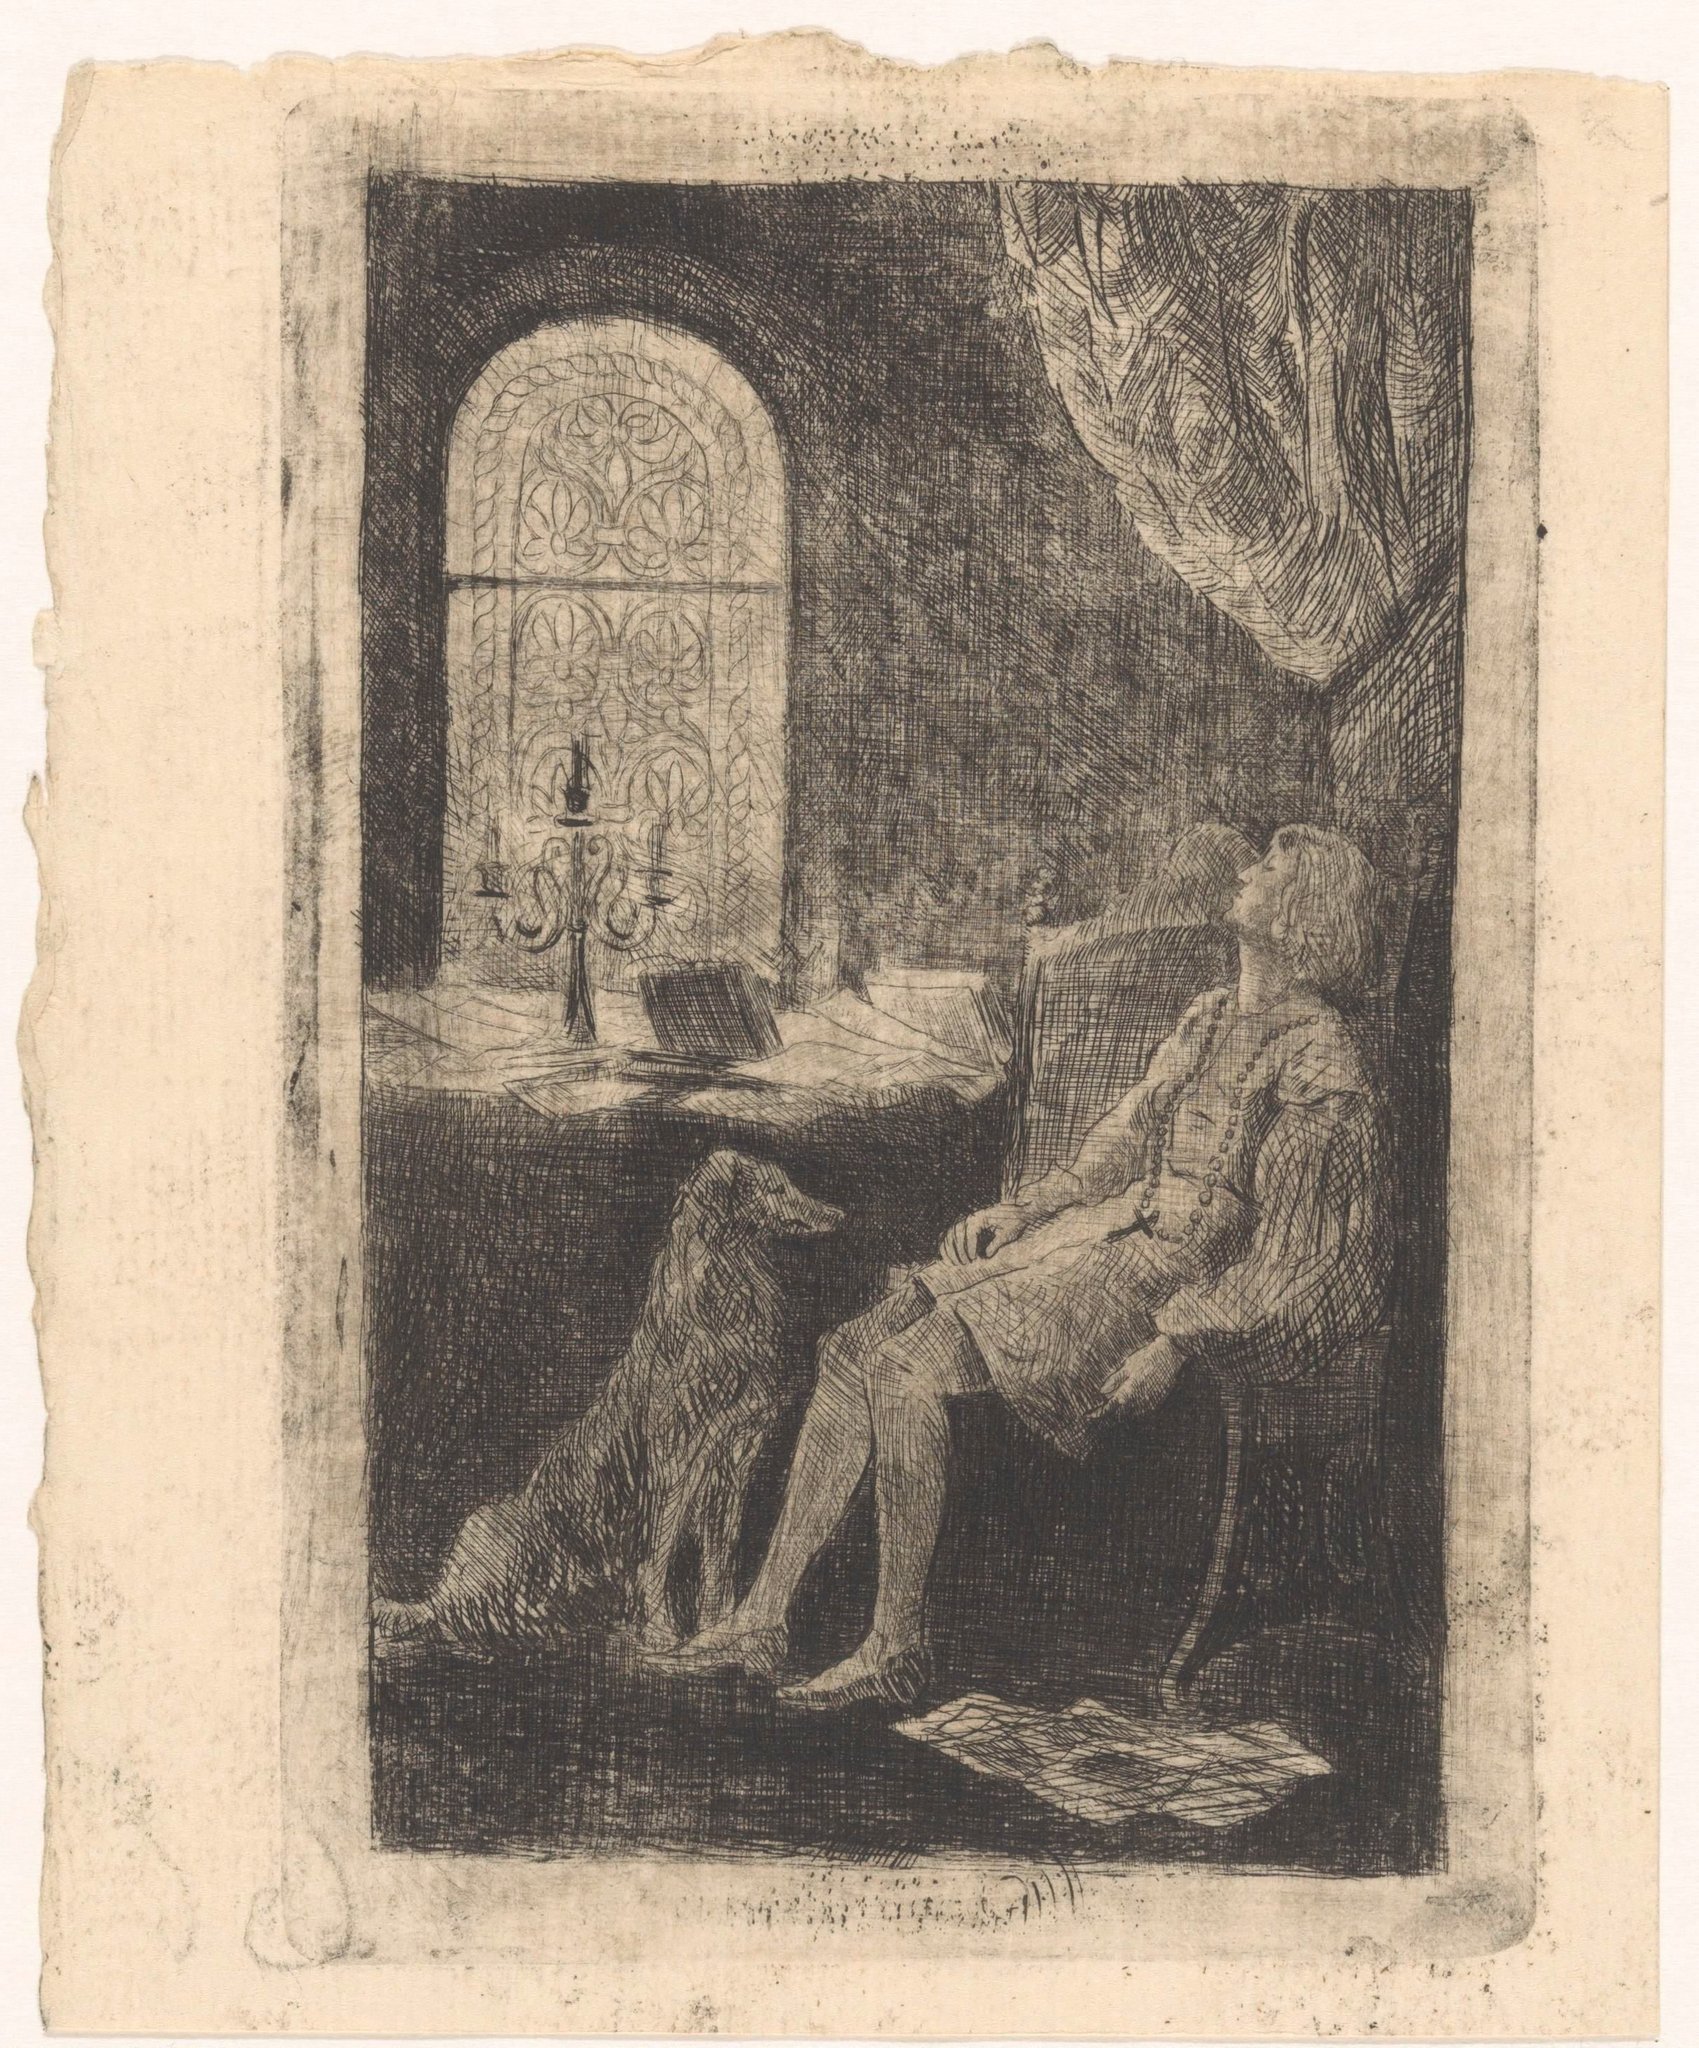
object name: print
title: Man en hond zittend bij een tafel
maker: geert grauss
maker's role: print maker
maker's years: 1882-1929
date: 1892-1929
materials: paper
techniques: etching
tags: sitting figure, paper (writing material), dog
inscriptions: collector's mark: Lugt 2760, collector's mark: Lugt 2228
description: Op de tafel een kandelaar, geopende boeken en losse papieren. Op de grond, bij de voeten van de man, nog meer losse papieren.